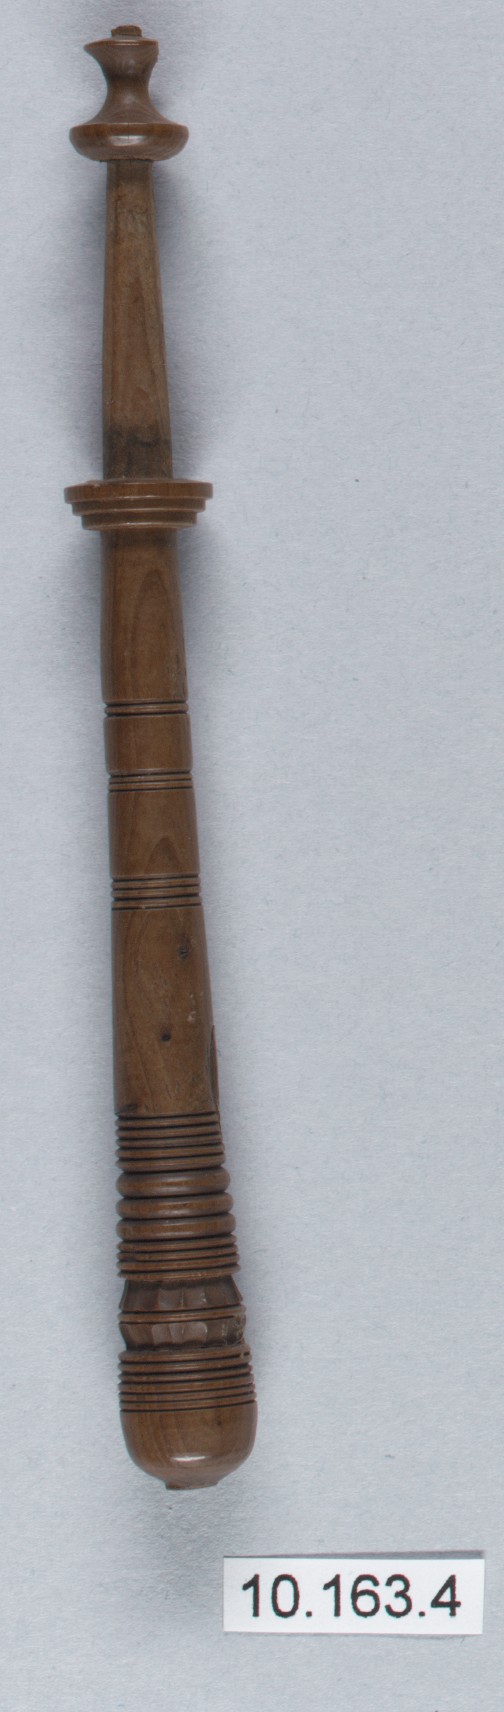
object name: bobbin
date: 1801-1900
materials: wood